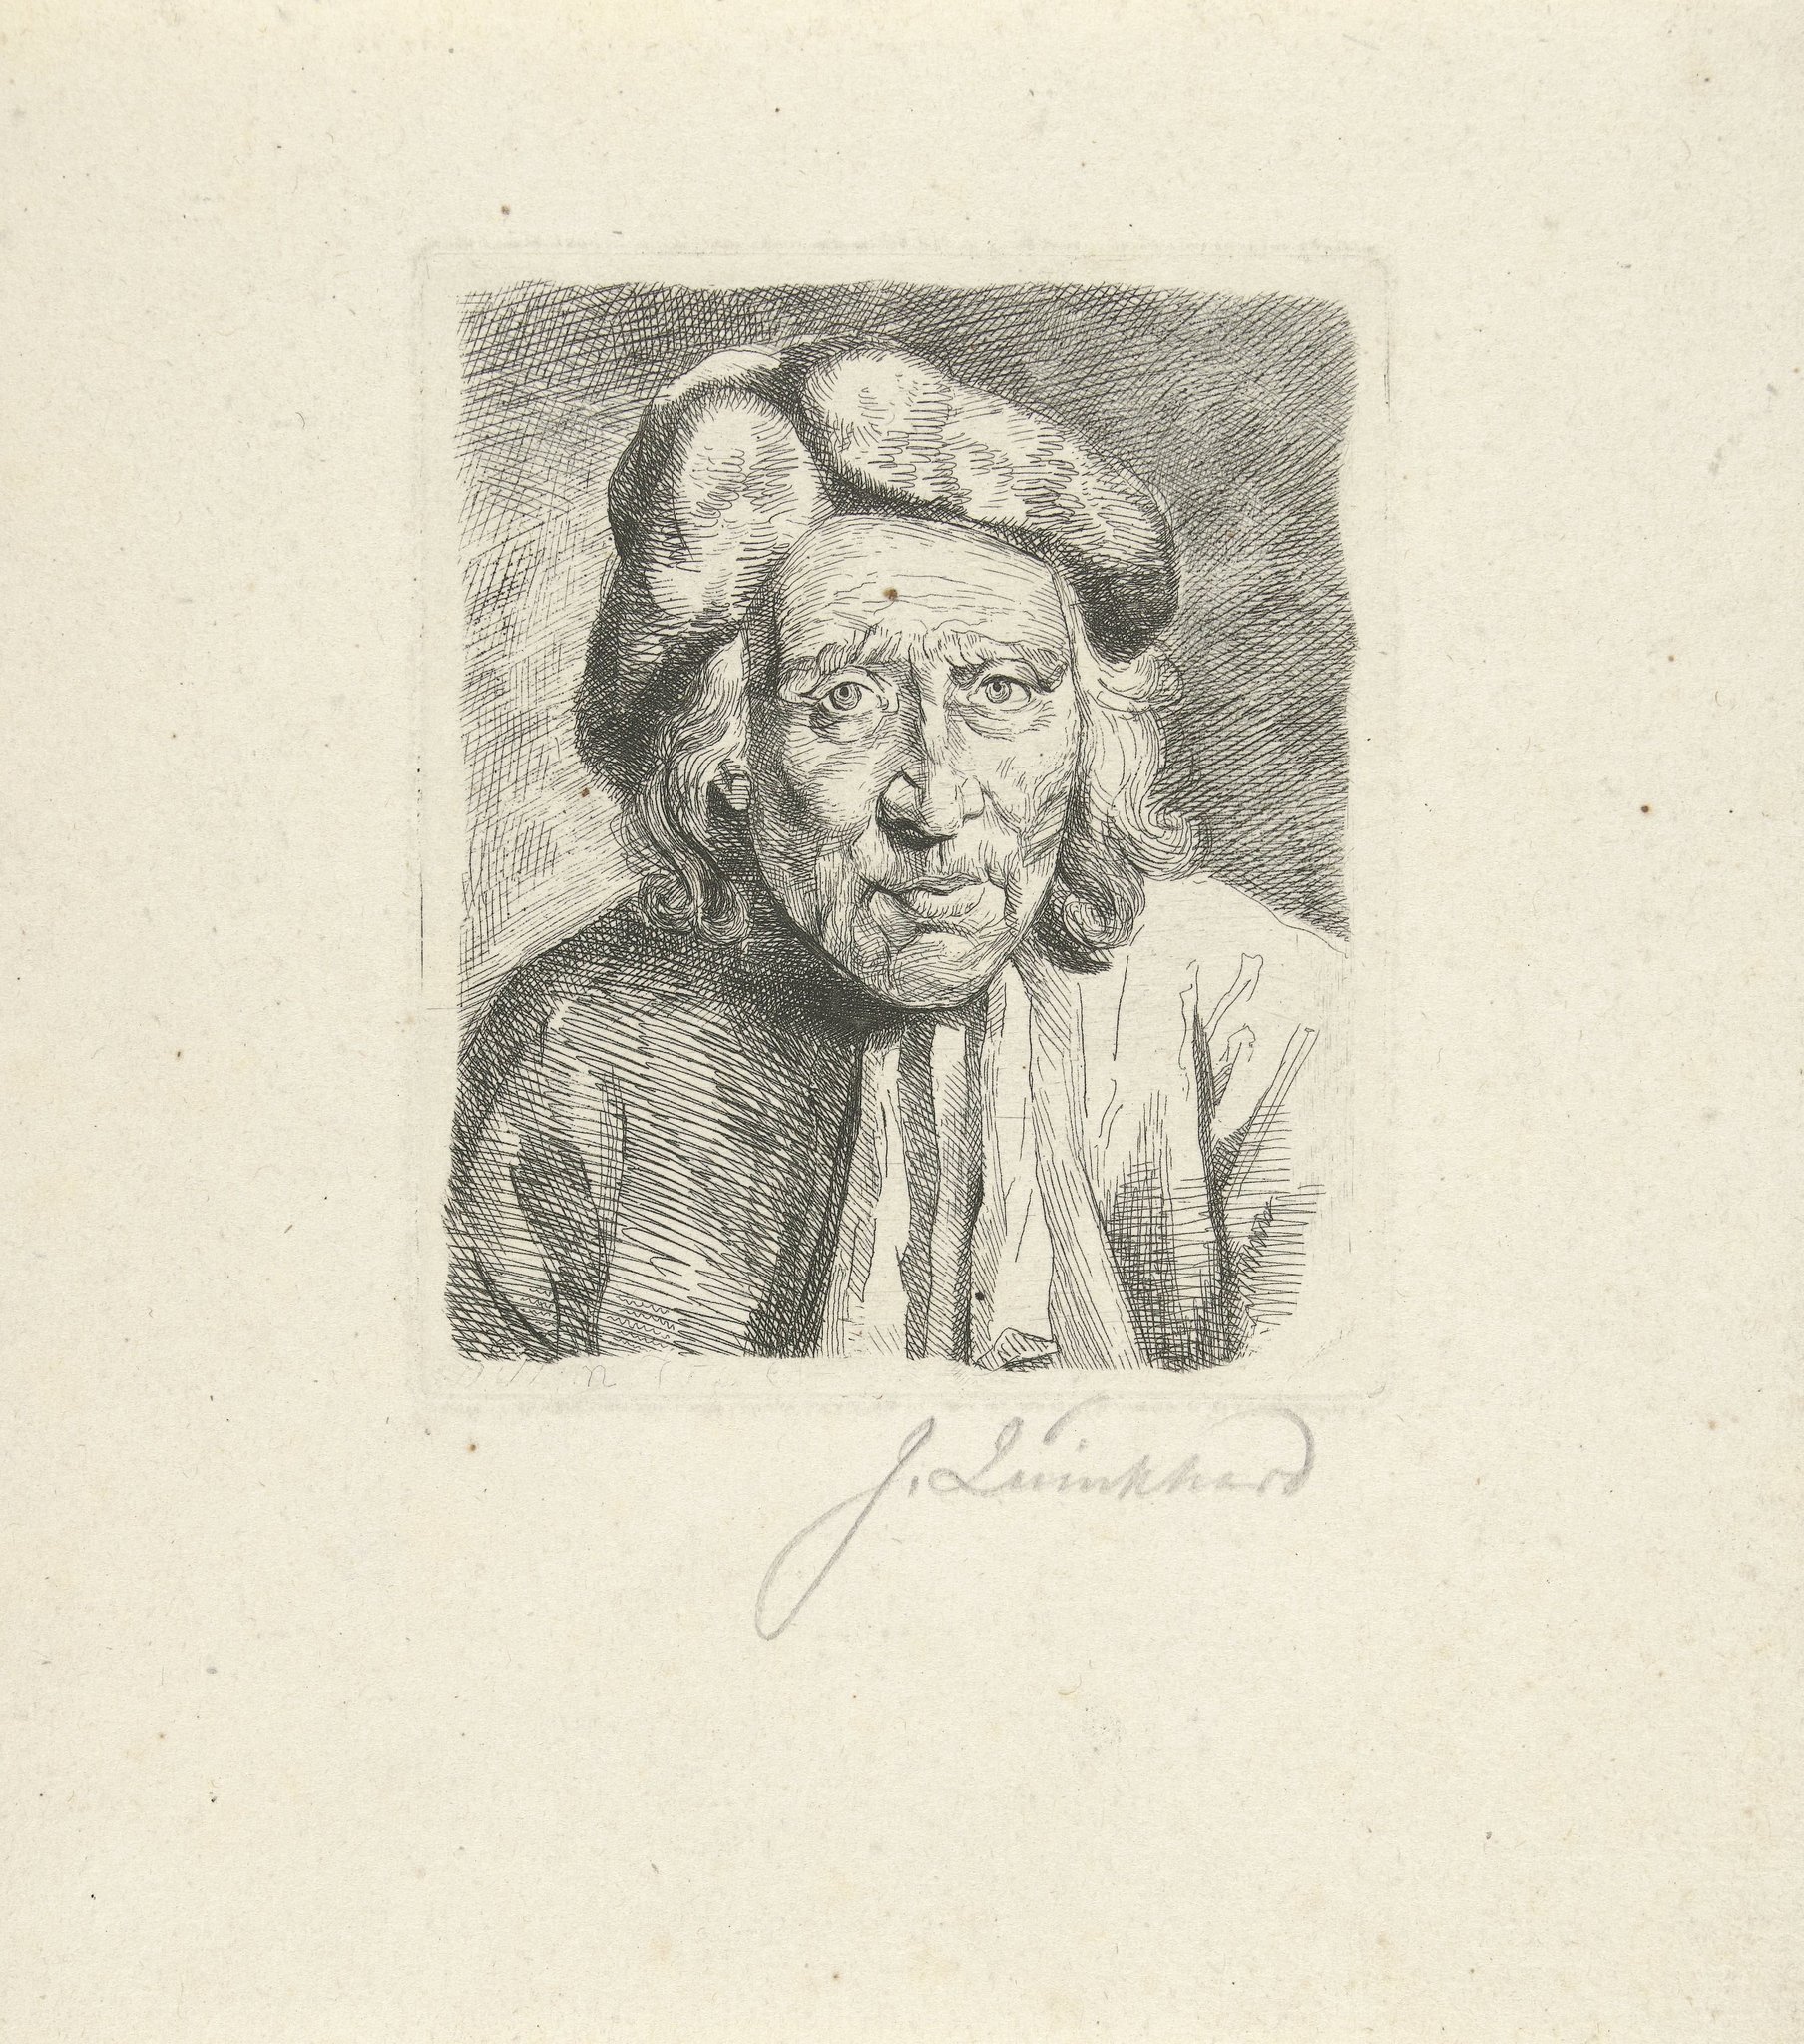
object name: print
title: Portret van Willem Jansz. Koster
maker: julius henricus quinkhard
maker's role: draughtsman, painter, print maker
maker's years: 1734-1795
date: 1744-1795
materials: paper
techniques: etching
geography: amsterdam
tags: head-gear: cap (+ men's clothes)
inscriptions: collector's mark: Lugt 2760, inscription: ‘J: Quinkhard’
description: Portret van Willem Jansz. Koster. Hij stierf te Muiden en werd 112 jaar.